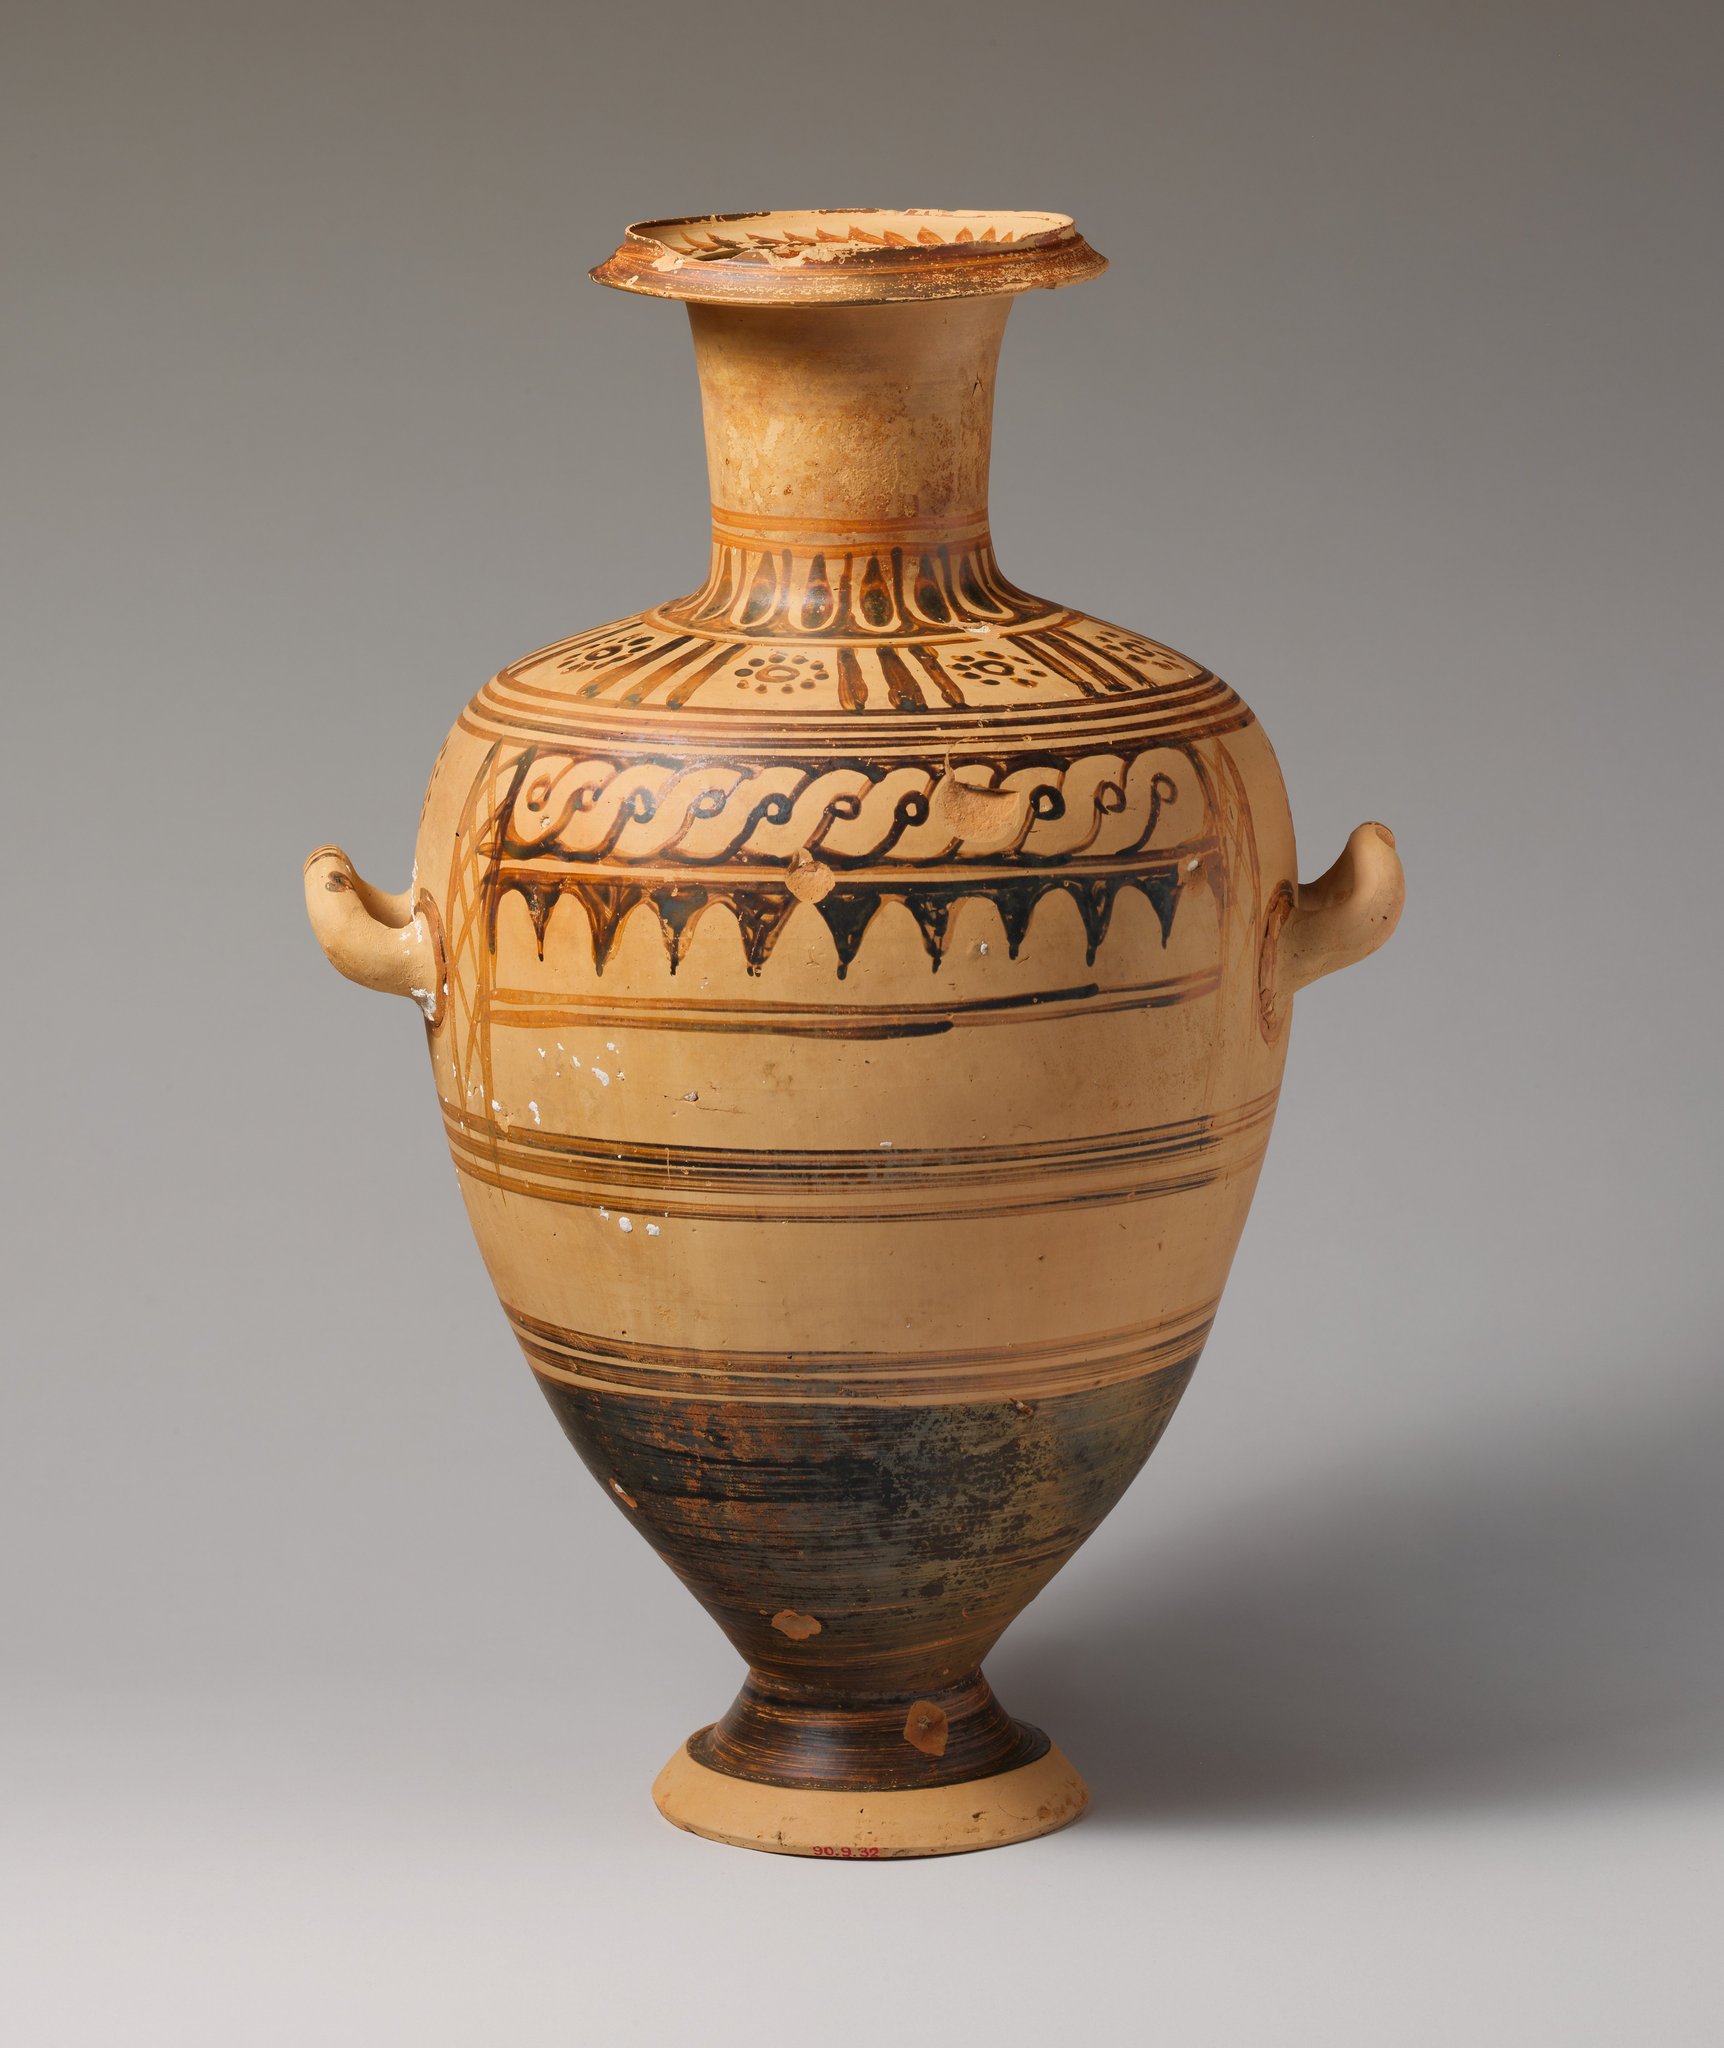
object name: hydria, hadra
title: Terracotta Hadra hydria (water jar)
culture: greek, cretan or ptolemaic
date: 234-201 BCE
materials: terracotta